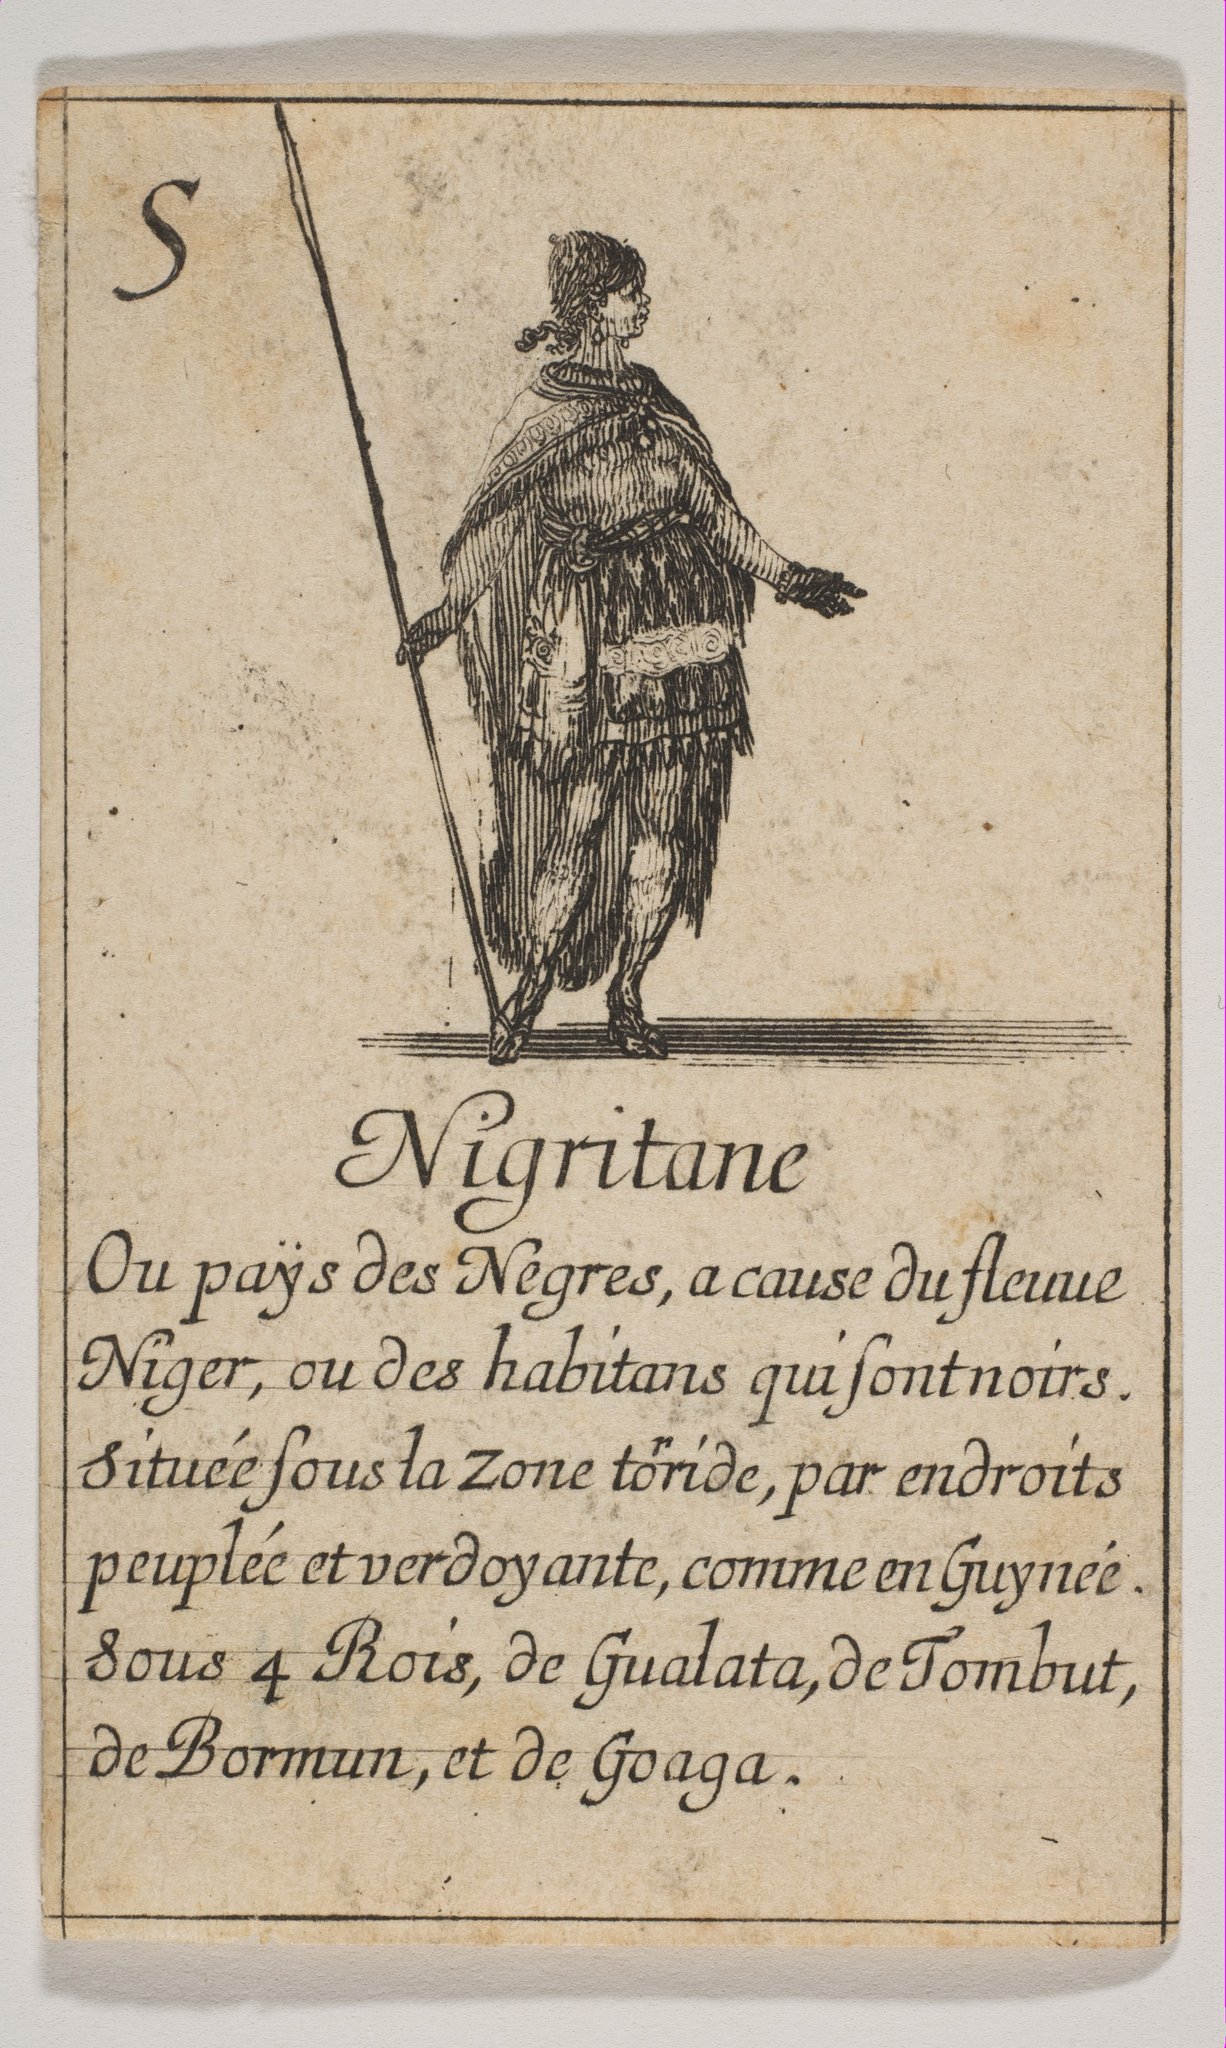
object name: print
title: Nigritane, from "Jeu de la Géographie"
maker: stefano della bella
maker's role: artist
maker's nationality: italian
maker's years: 1610-1664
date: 1644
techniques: etching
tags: soldiers